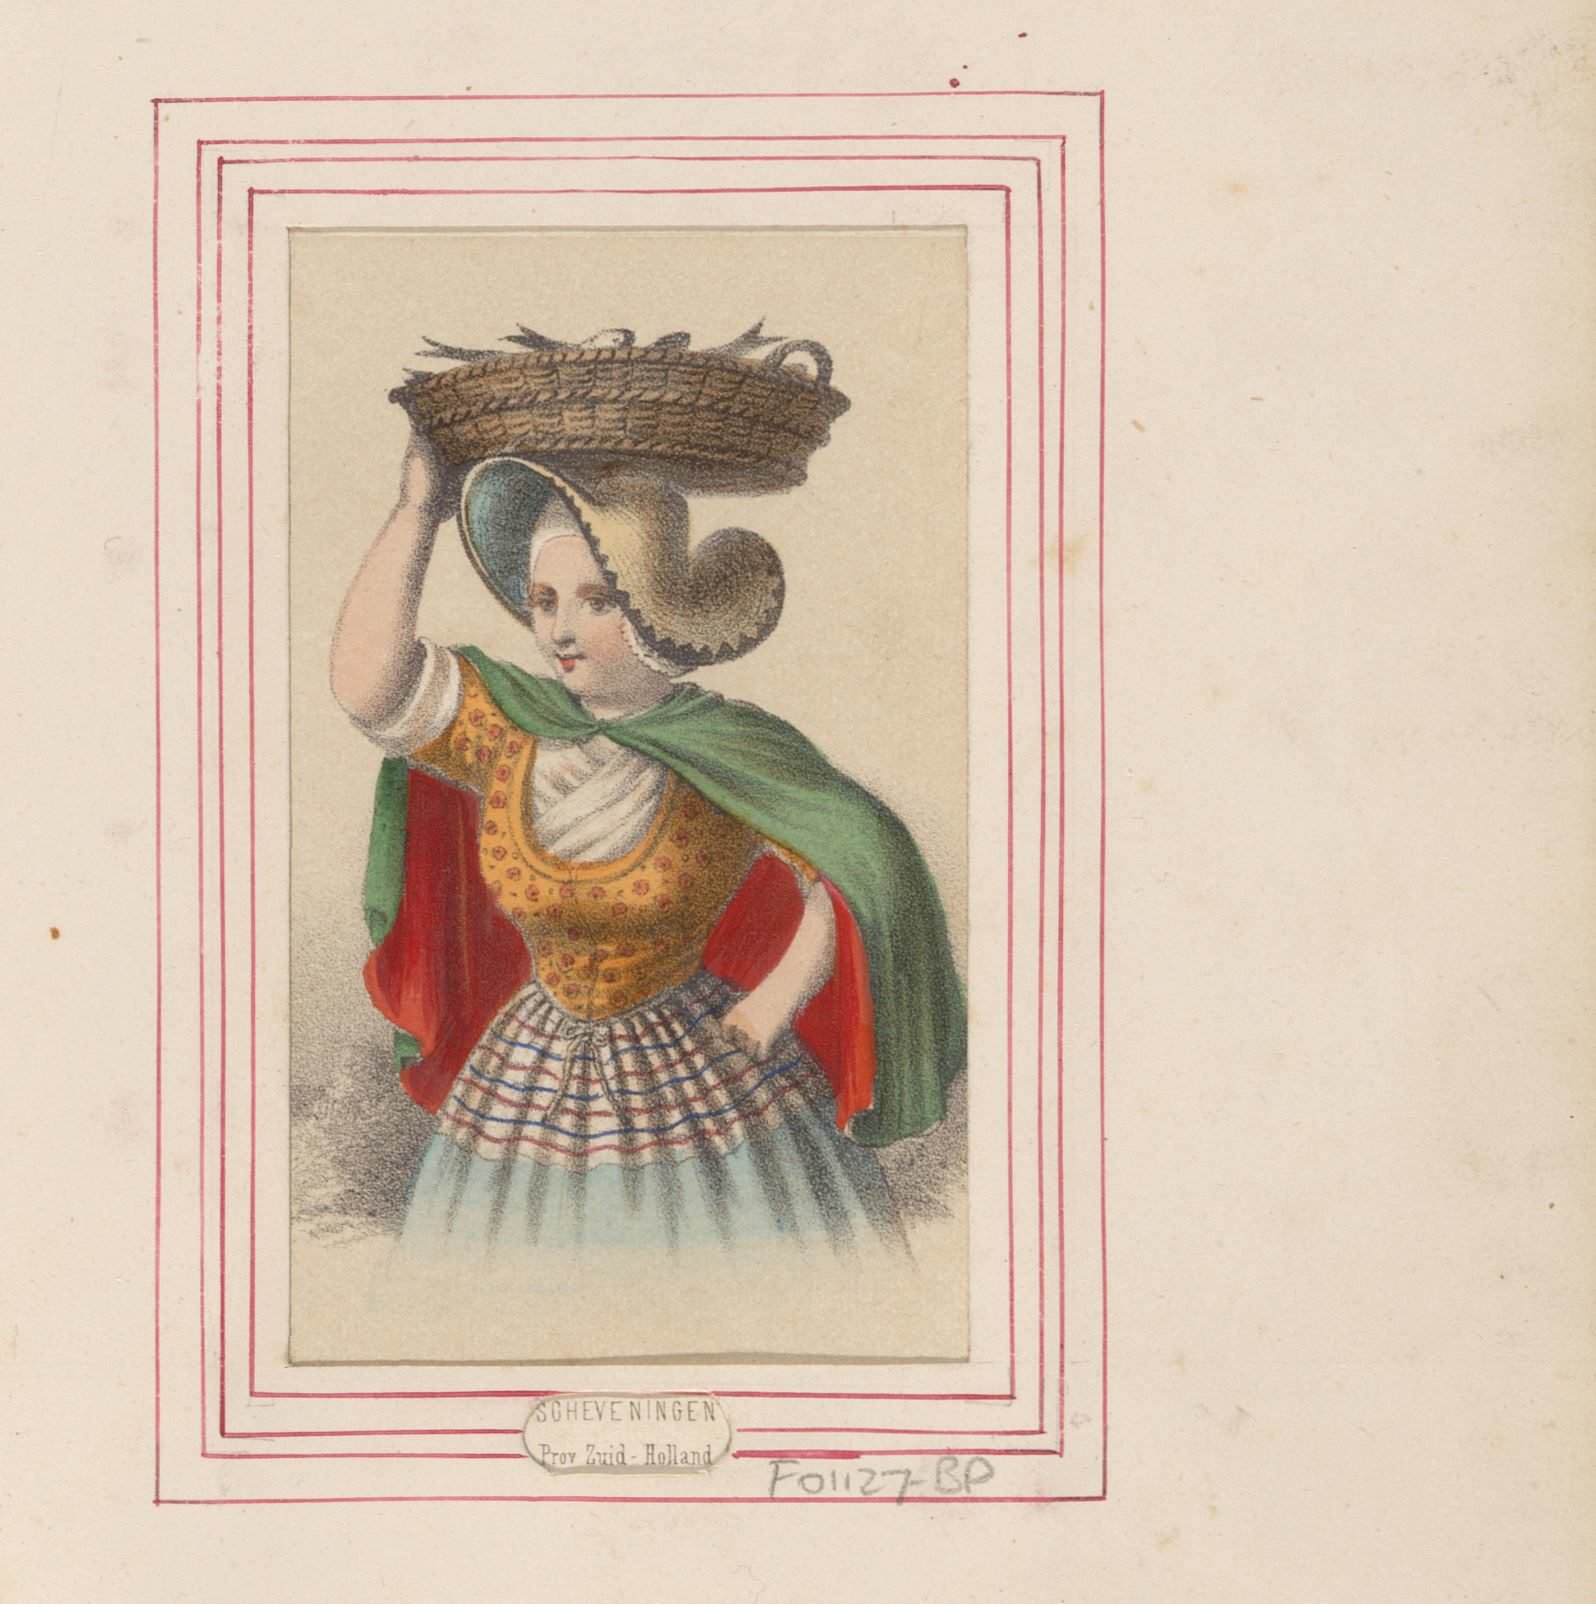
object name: print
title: Vrouw in de klederdracht van Scheveningen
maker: Anonymous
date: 1865-1875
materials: paper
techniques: lithograph, hand coloring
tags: folk costume, regional costume (+ women's clothes), head-gear: cap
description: Onderdeel van Album met foto's en litho's van bezienswaardigheden in Noord- en Zuid-Hollandse steden, schilderijen en klederdrachten.